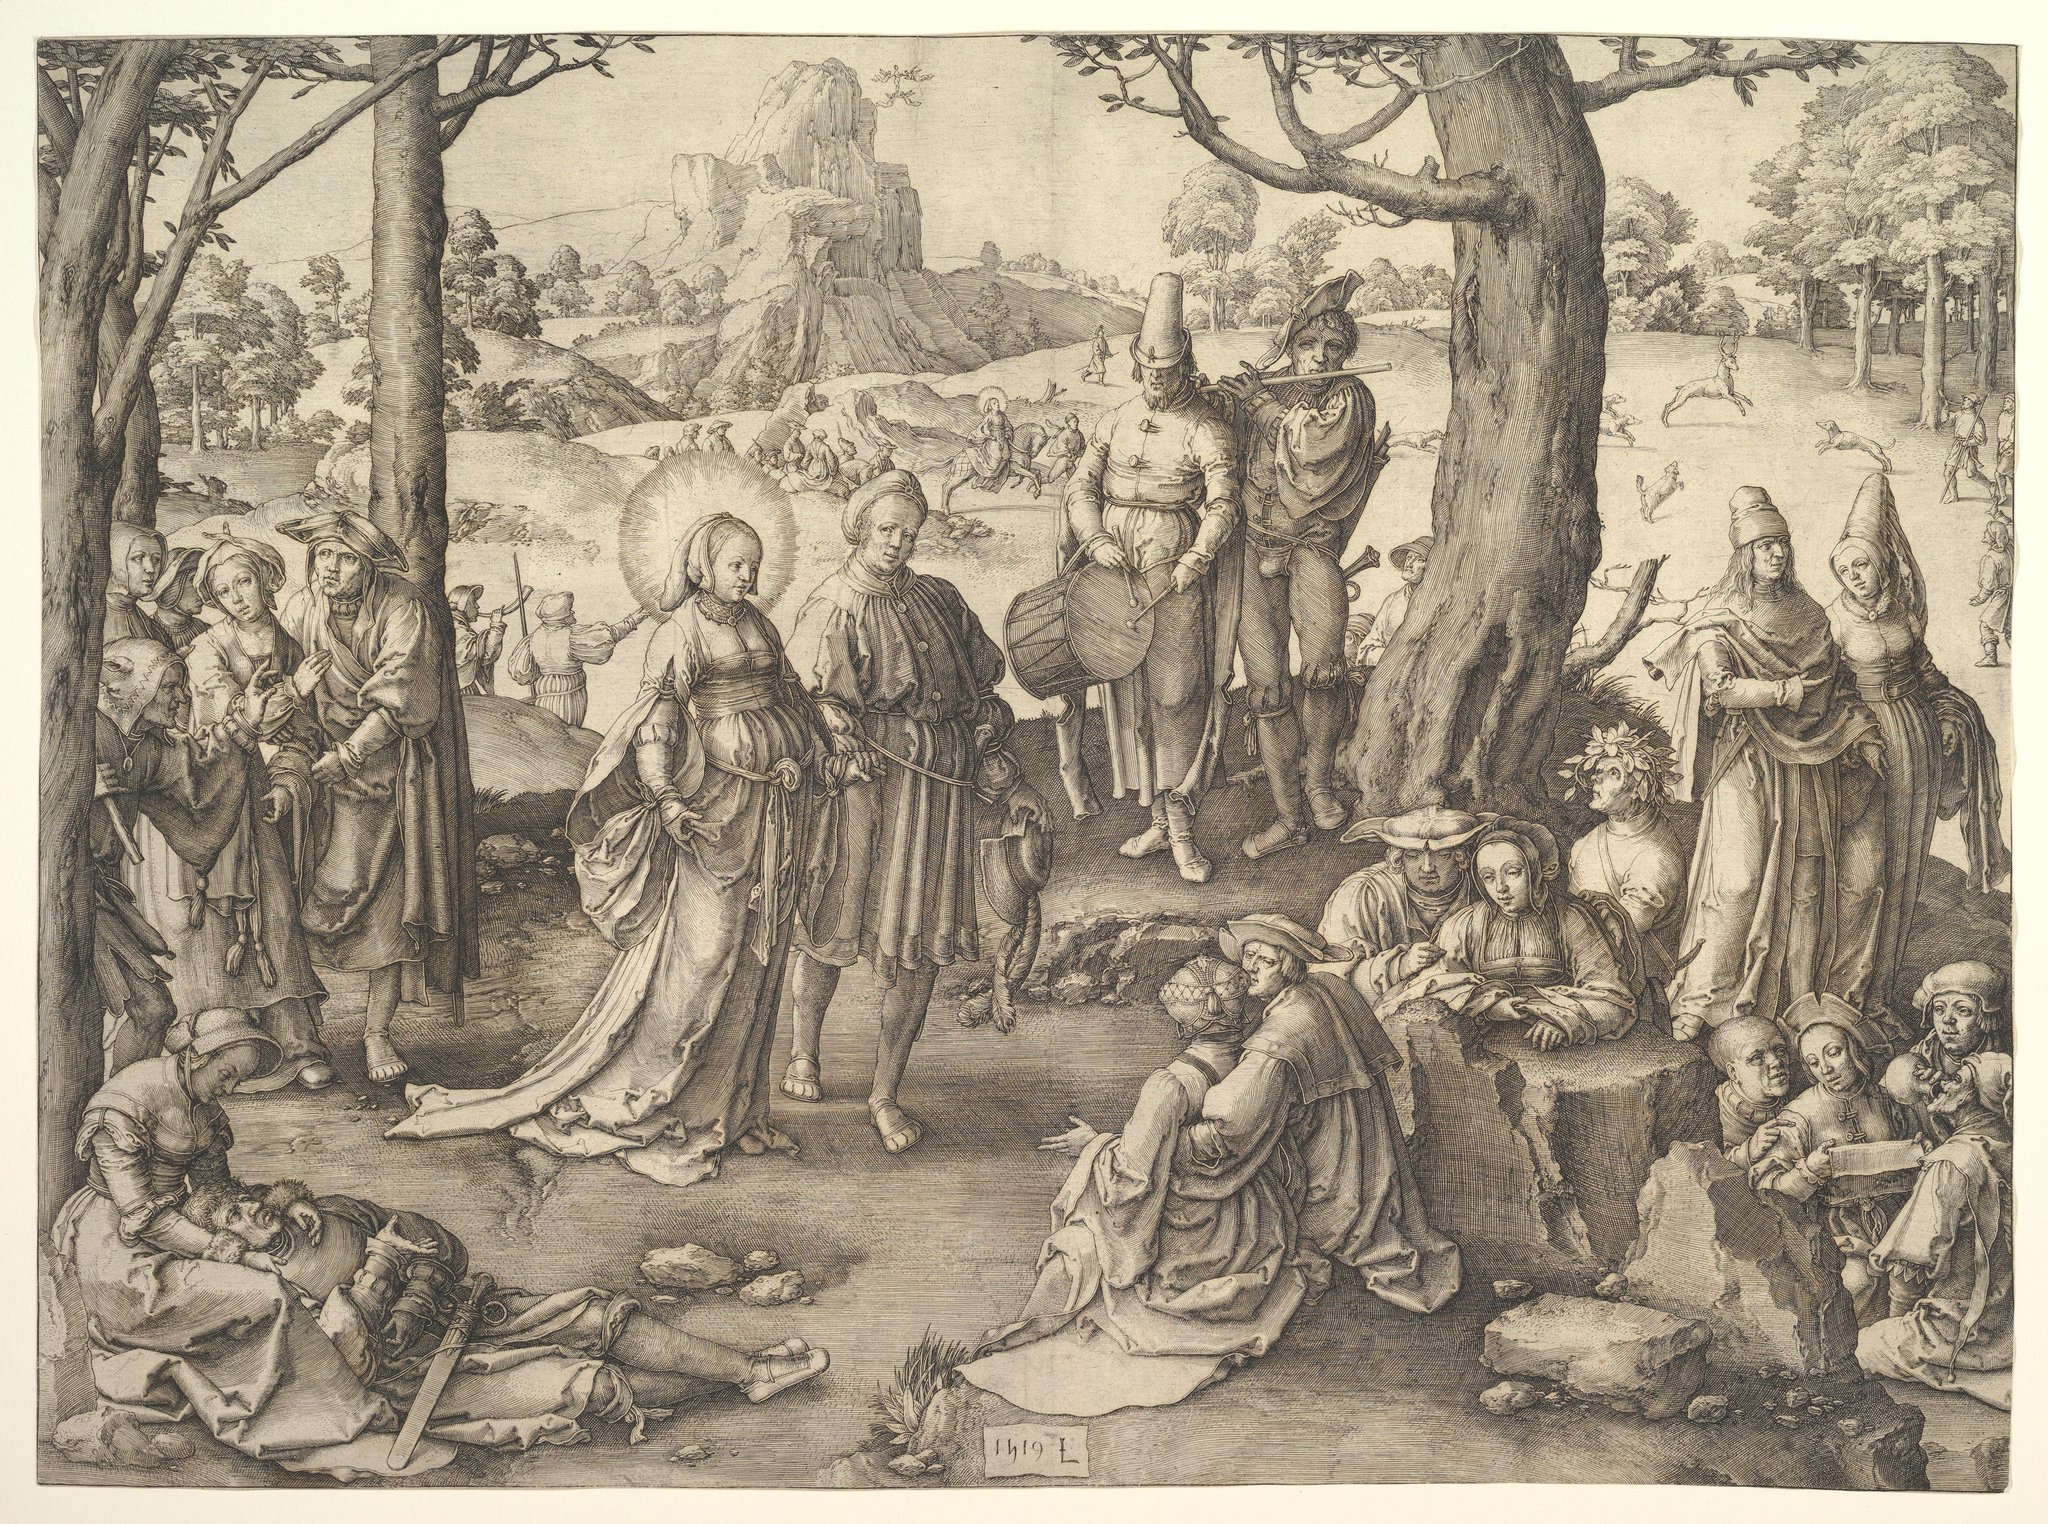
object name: print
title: The Dance of the Magdalene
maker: lucas van leyden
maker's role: artist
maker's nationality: netherlandish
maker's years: 1494-1533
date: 1519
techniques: engraving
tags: men,women,mary magdalene,musicians